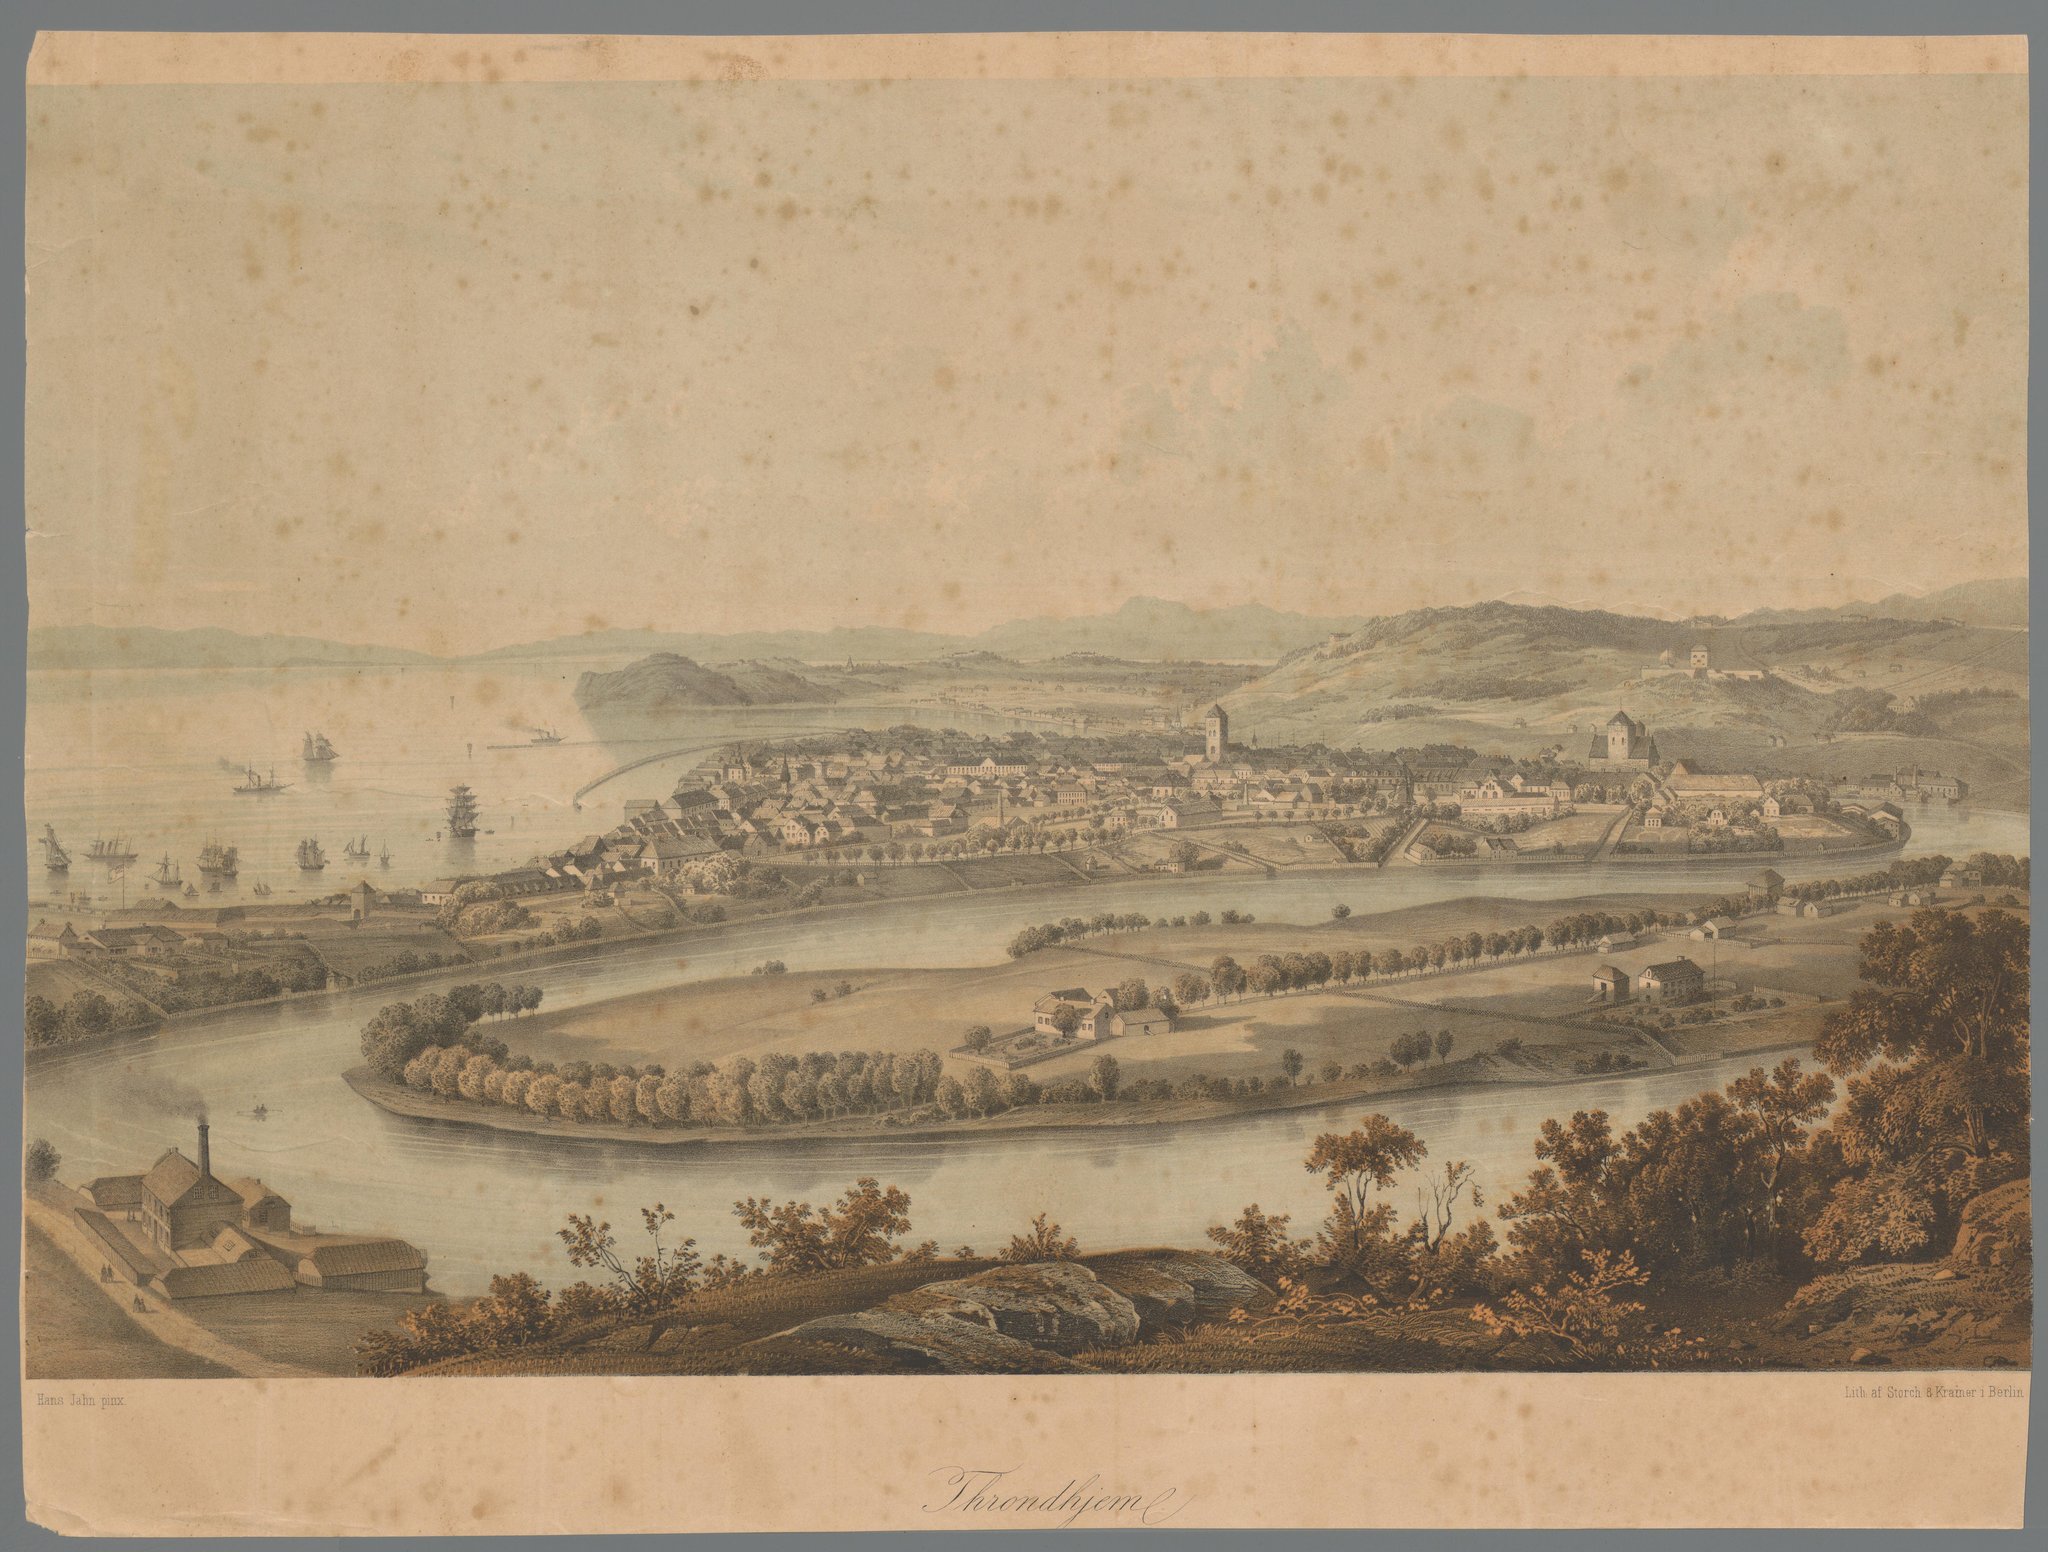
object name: print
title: Gezicht op Trondheim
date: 1840-1875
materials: paper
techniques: tone lithography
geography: berlin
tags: city-view, and landscape with man-made constructions, water course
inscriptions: collector's mark: Lugt 2228